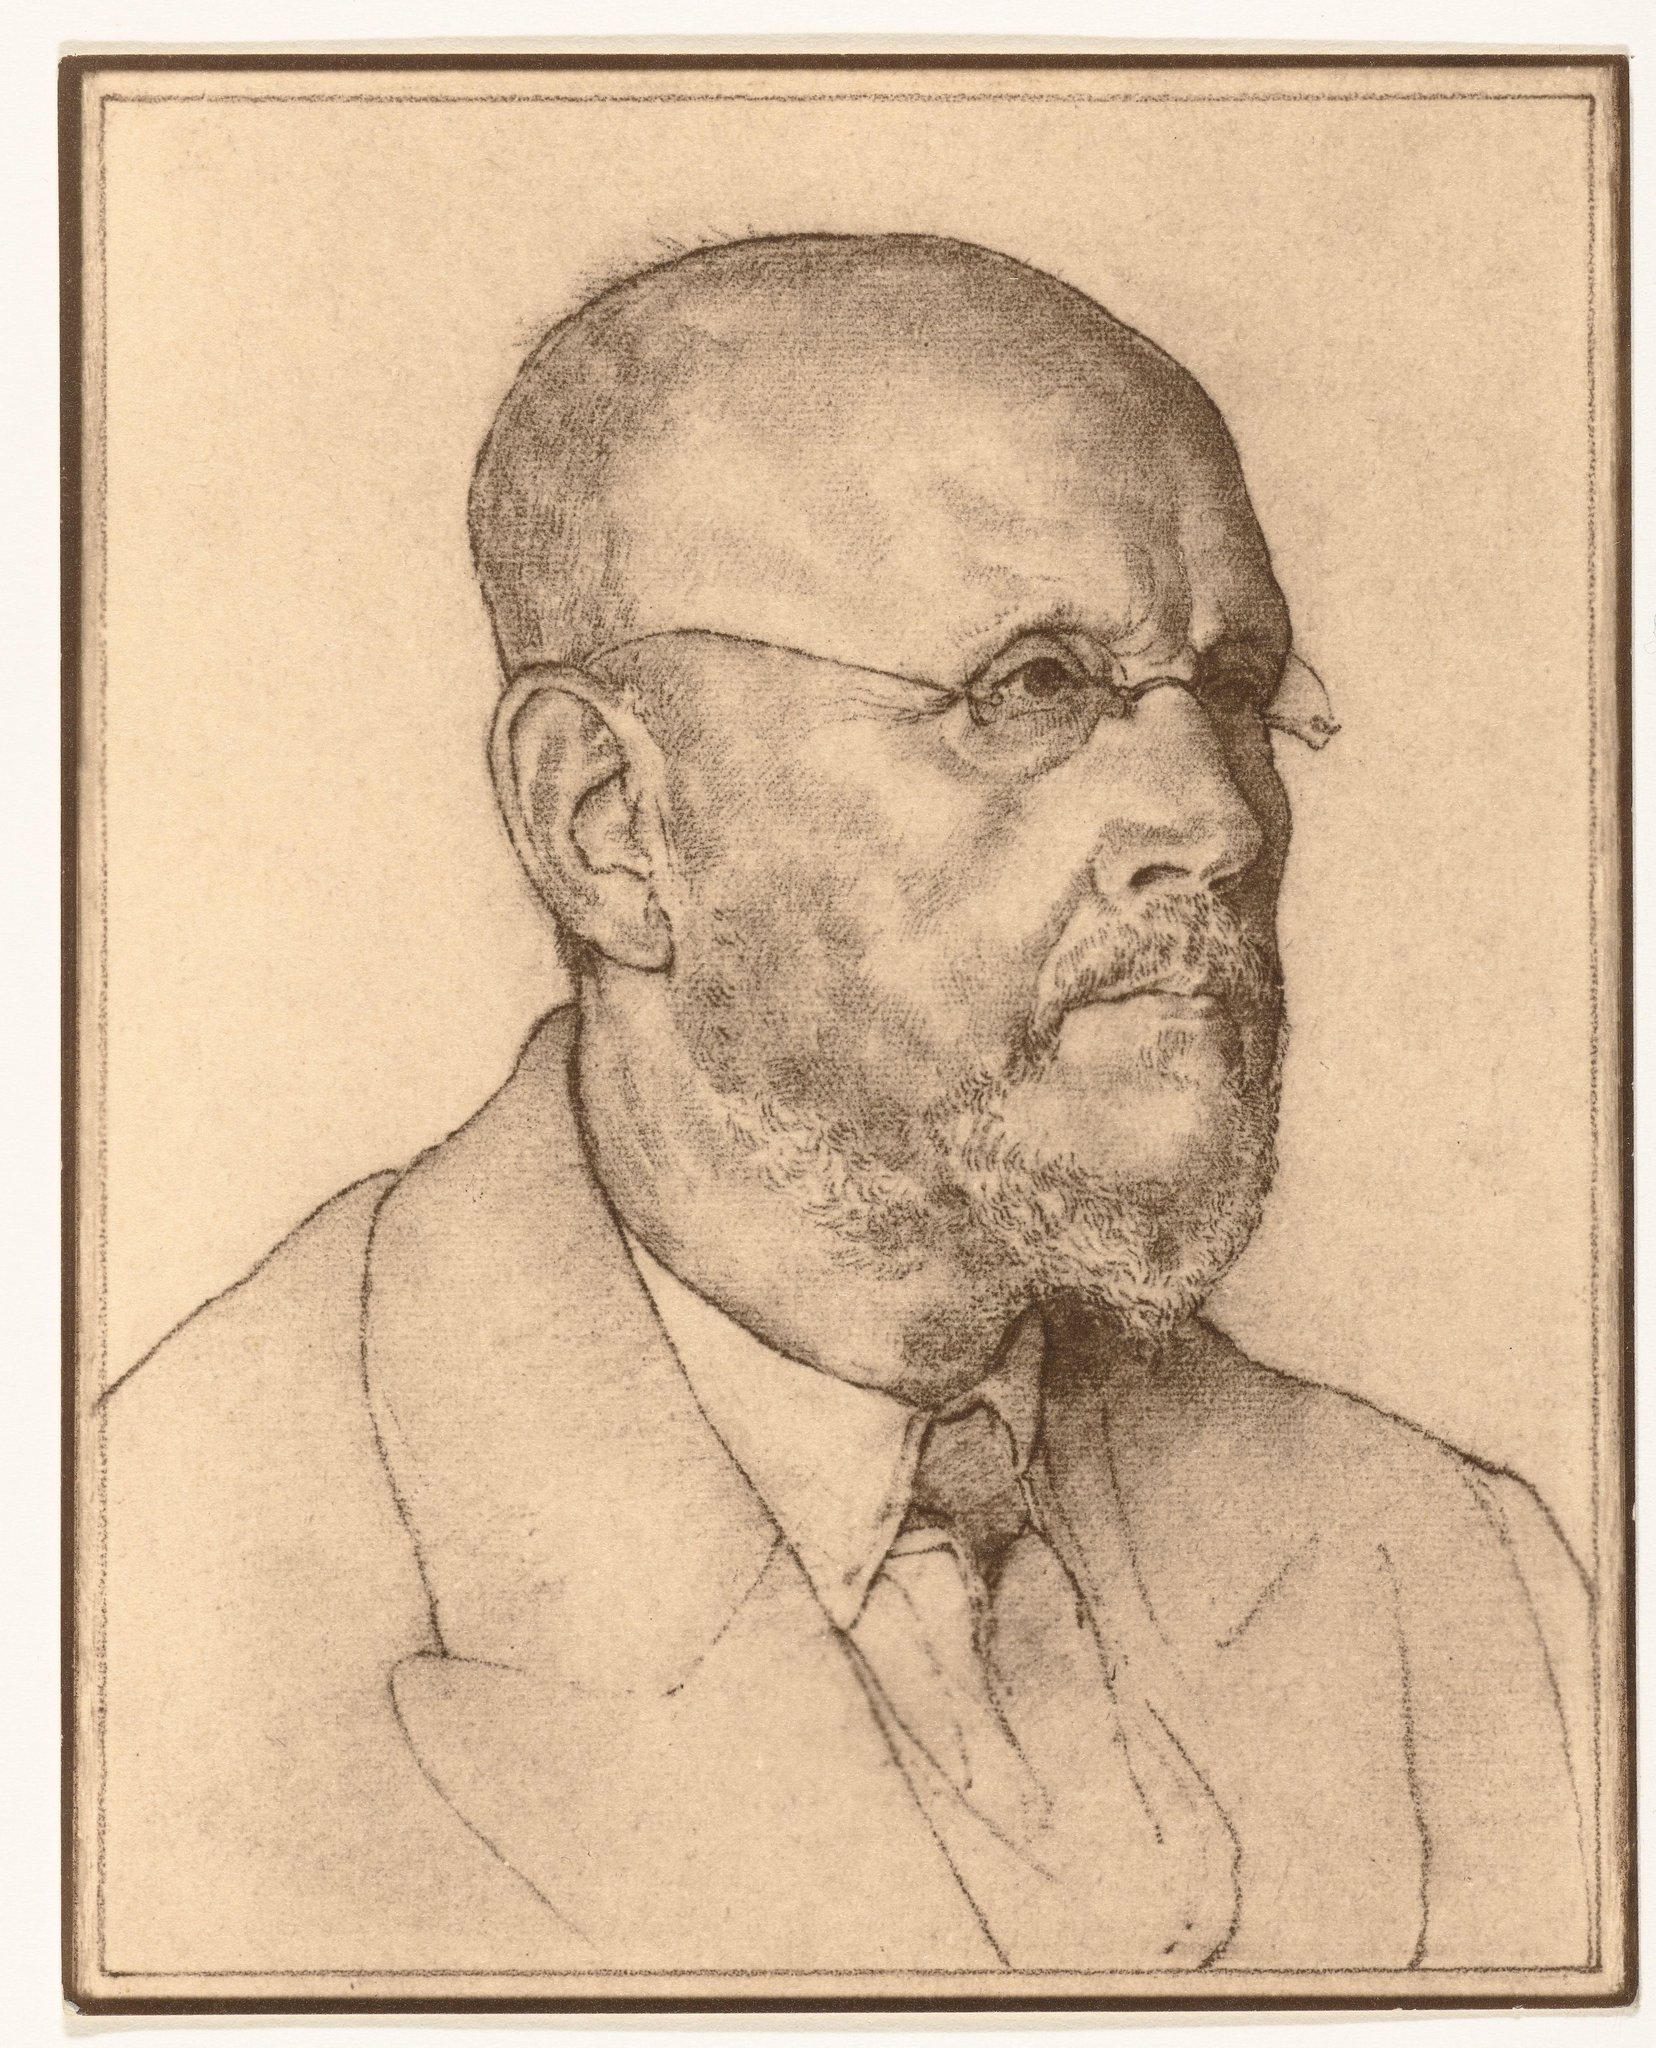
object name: photograph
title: Fotoreproductie van een portret van een man door Han van der Kop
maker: adriaan bijl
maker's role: fotograaf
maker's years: 1874-1967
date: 1930-1940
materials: paper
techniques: gelatin silver print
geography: amsterdam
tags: drawing, historical persons